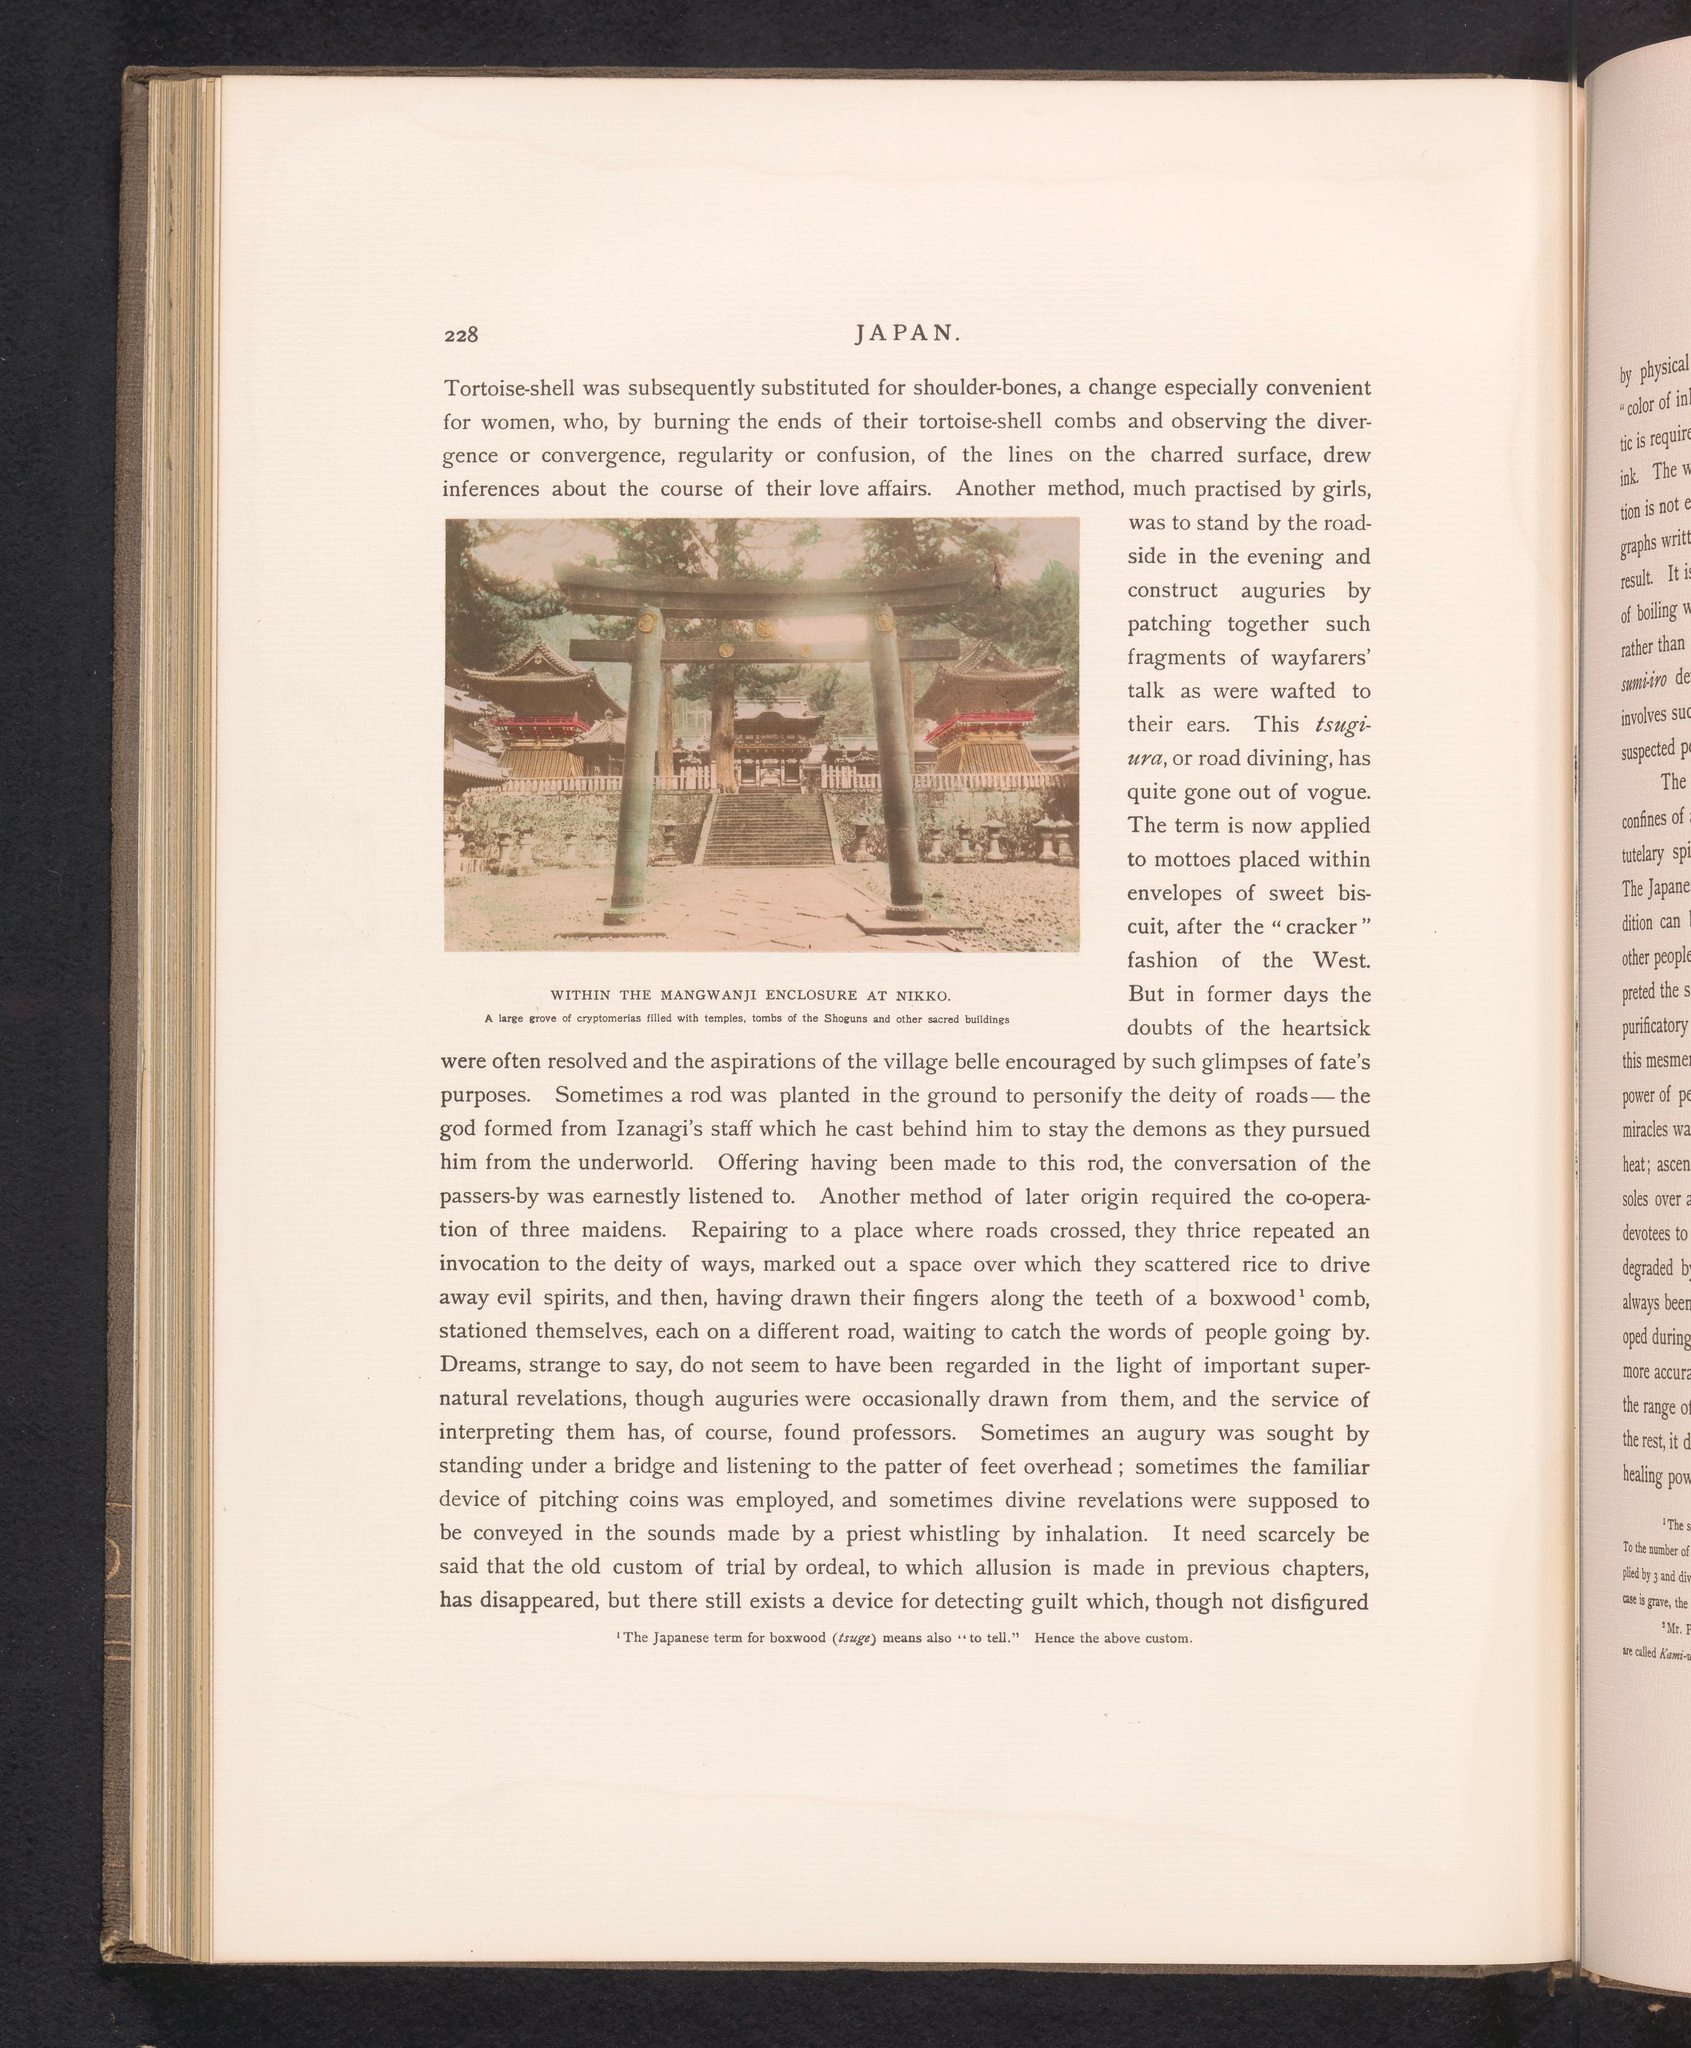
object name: page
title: Within the Mangwanji enclosure at Nikko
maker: Anonymous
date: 1887-1897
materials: photographic support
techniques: albumen print, hand coloring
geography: japan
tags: temple, shrine ~ shinto, gate, entrance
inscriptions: inscription: ‘A large grove of cryptomerias filled with temples, tombs of the Shoguns and other sacred buildings’